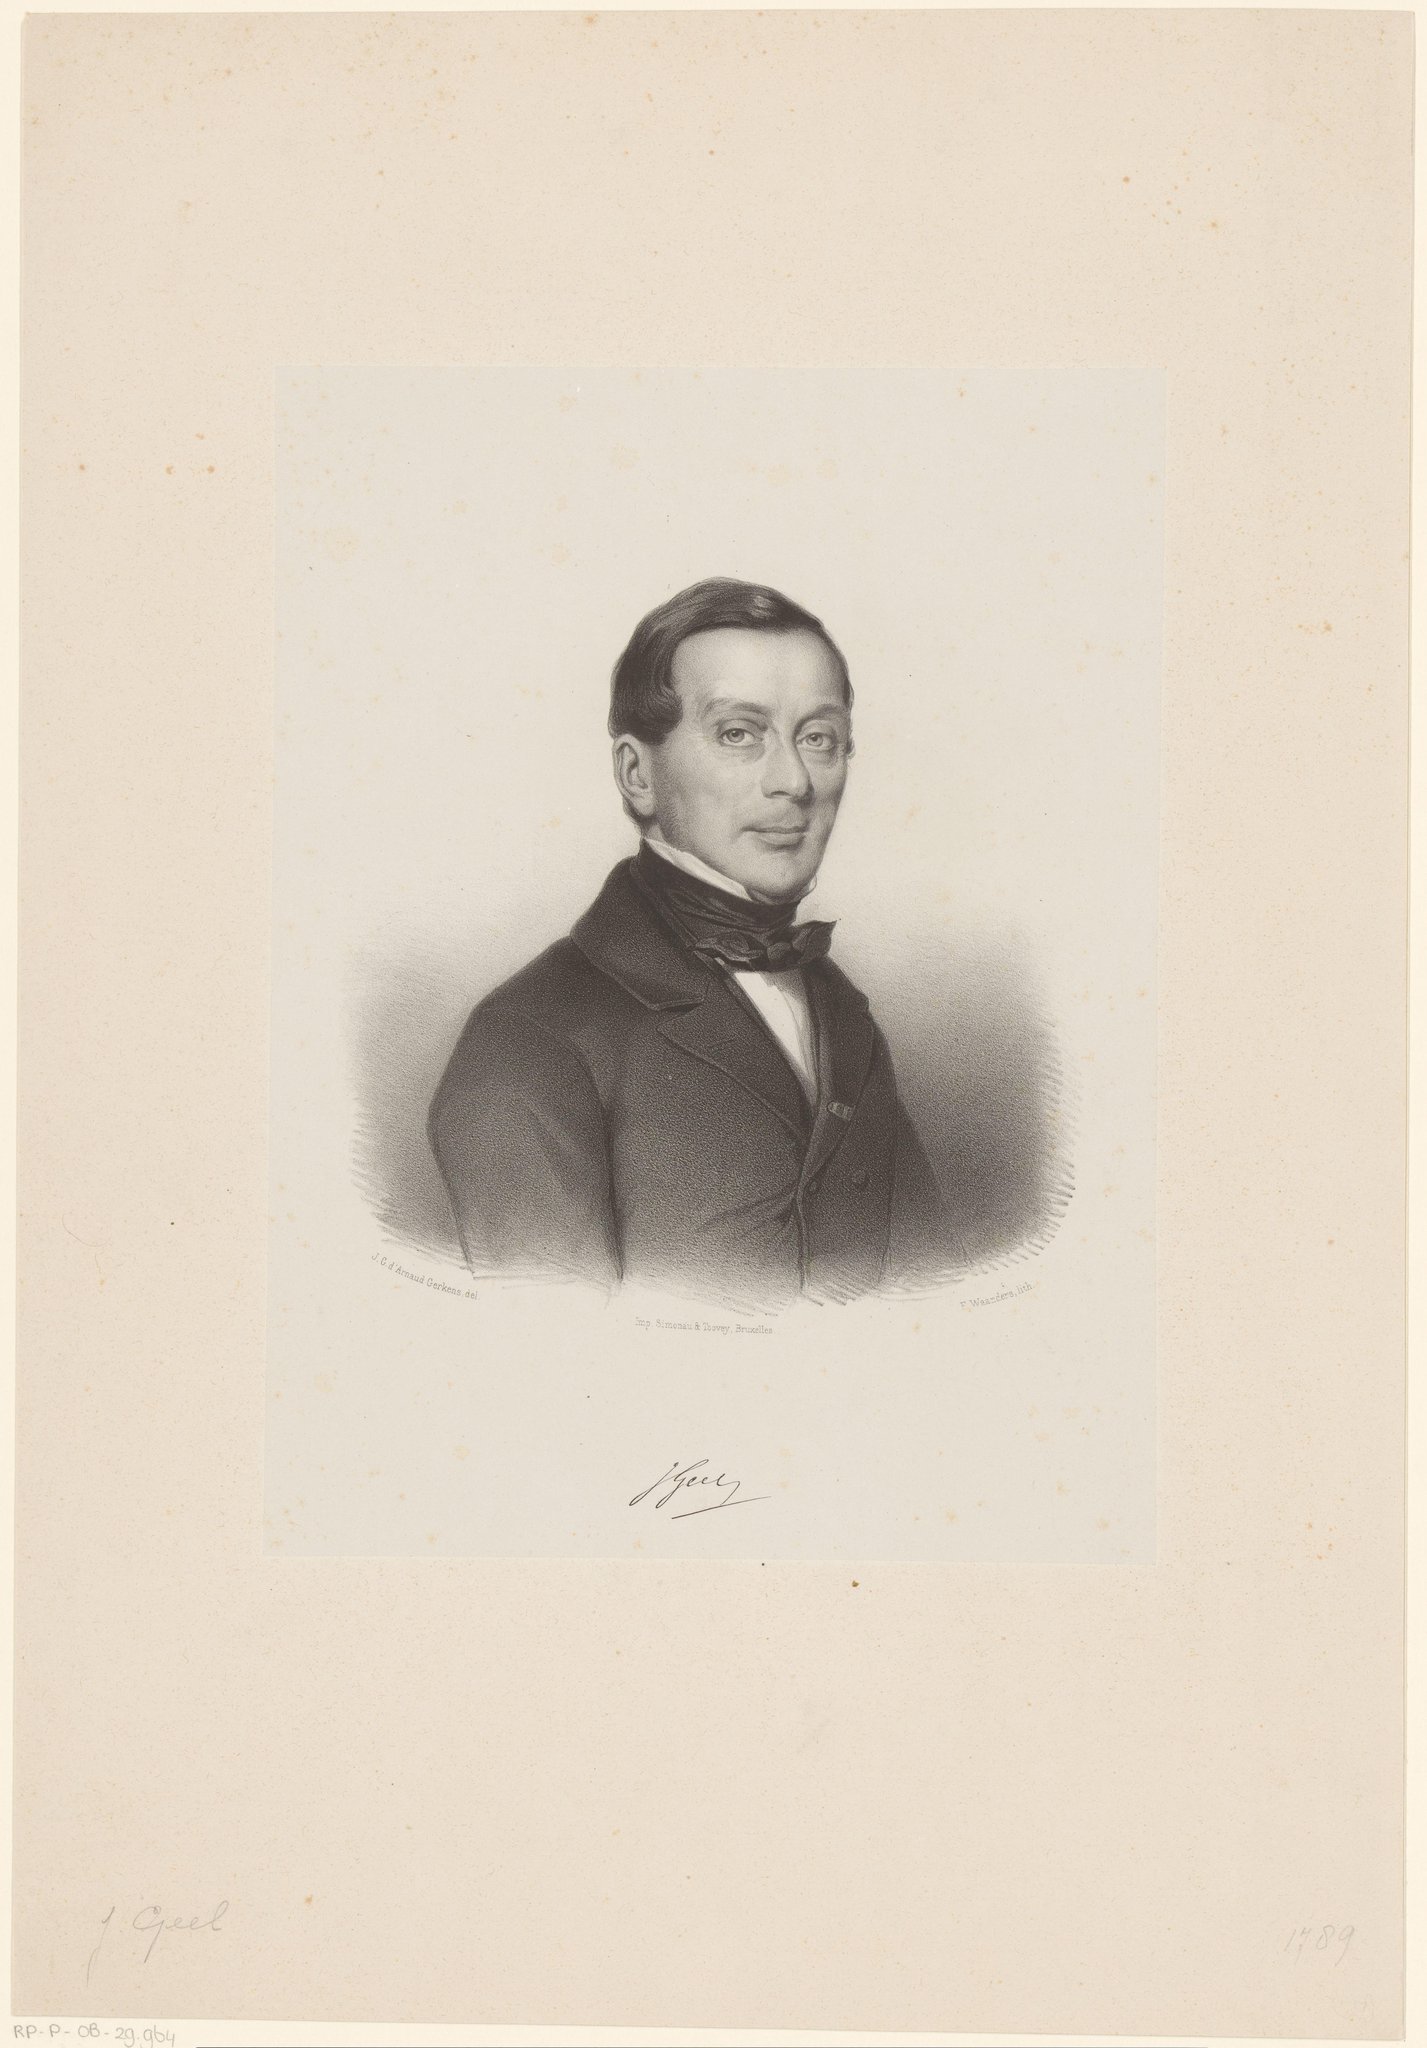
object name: print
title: Portret van Jacob Geel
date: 1847-1875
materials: paper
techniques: lithograph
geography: brussels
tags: amsterdam, the hague, historical persons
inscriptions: collector's mark: Lugt 2228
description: Onder het portret de signatuur van de geportretteerde.